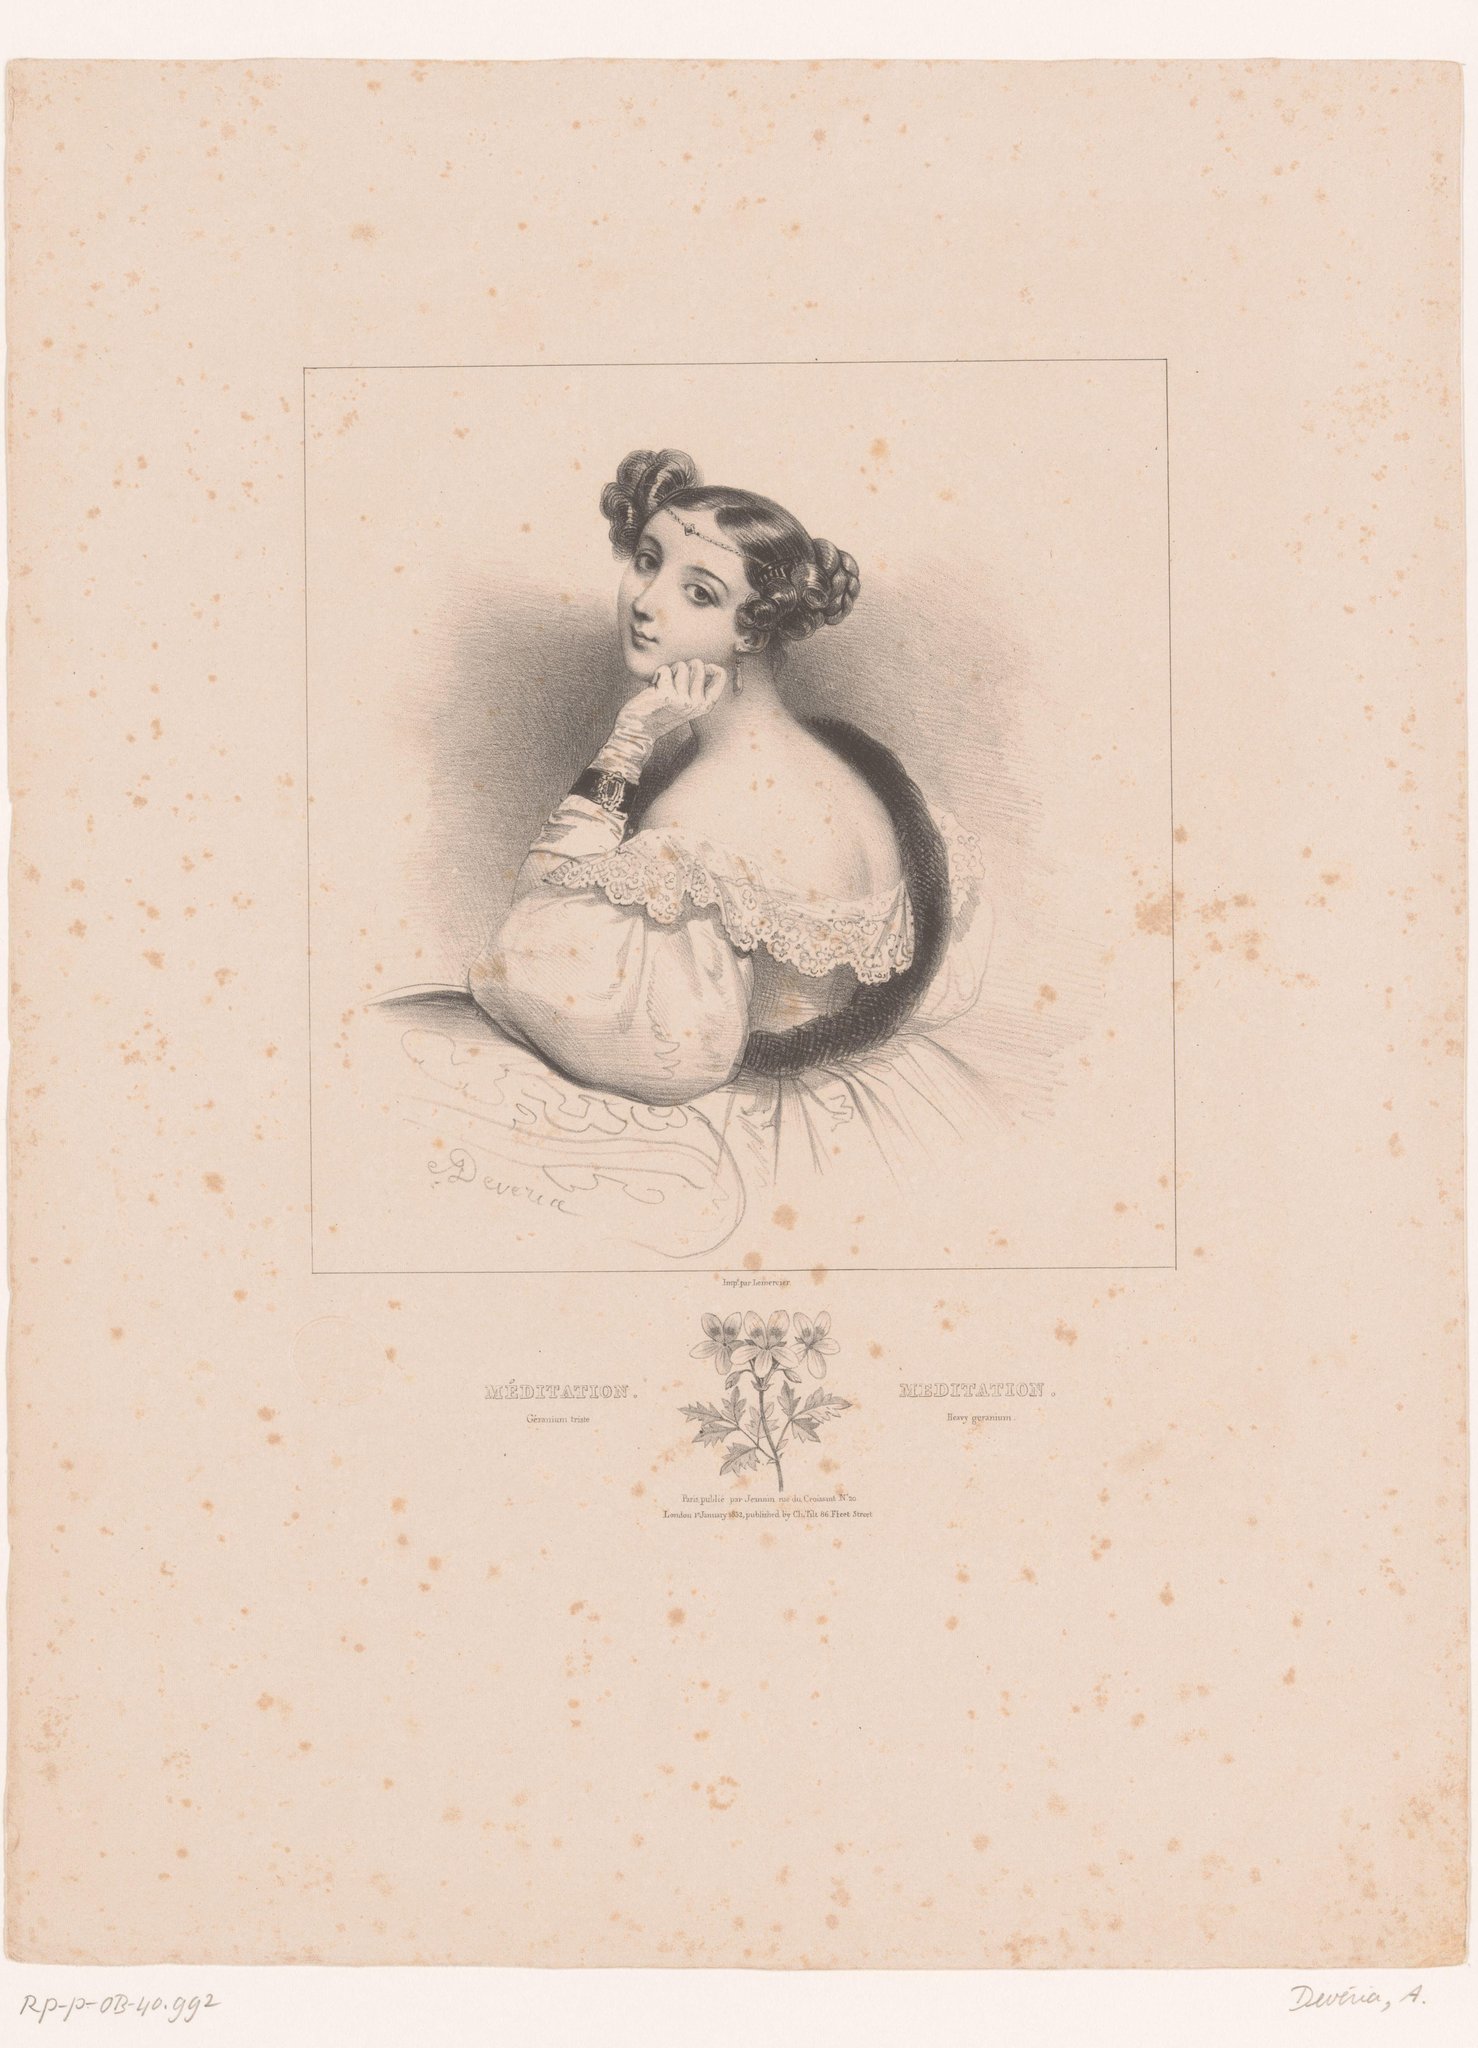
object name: print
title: Le langage des fleurs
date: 1831-1832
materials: paper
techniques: lithograph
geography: london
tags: flowers, adolescent, young woman, maiden, mental prayer, meditation; 'meditatione', 'meditatione spirituale' (ripa)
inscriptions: check stamp: Lugt 3987